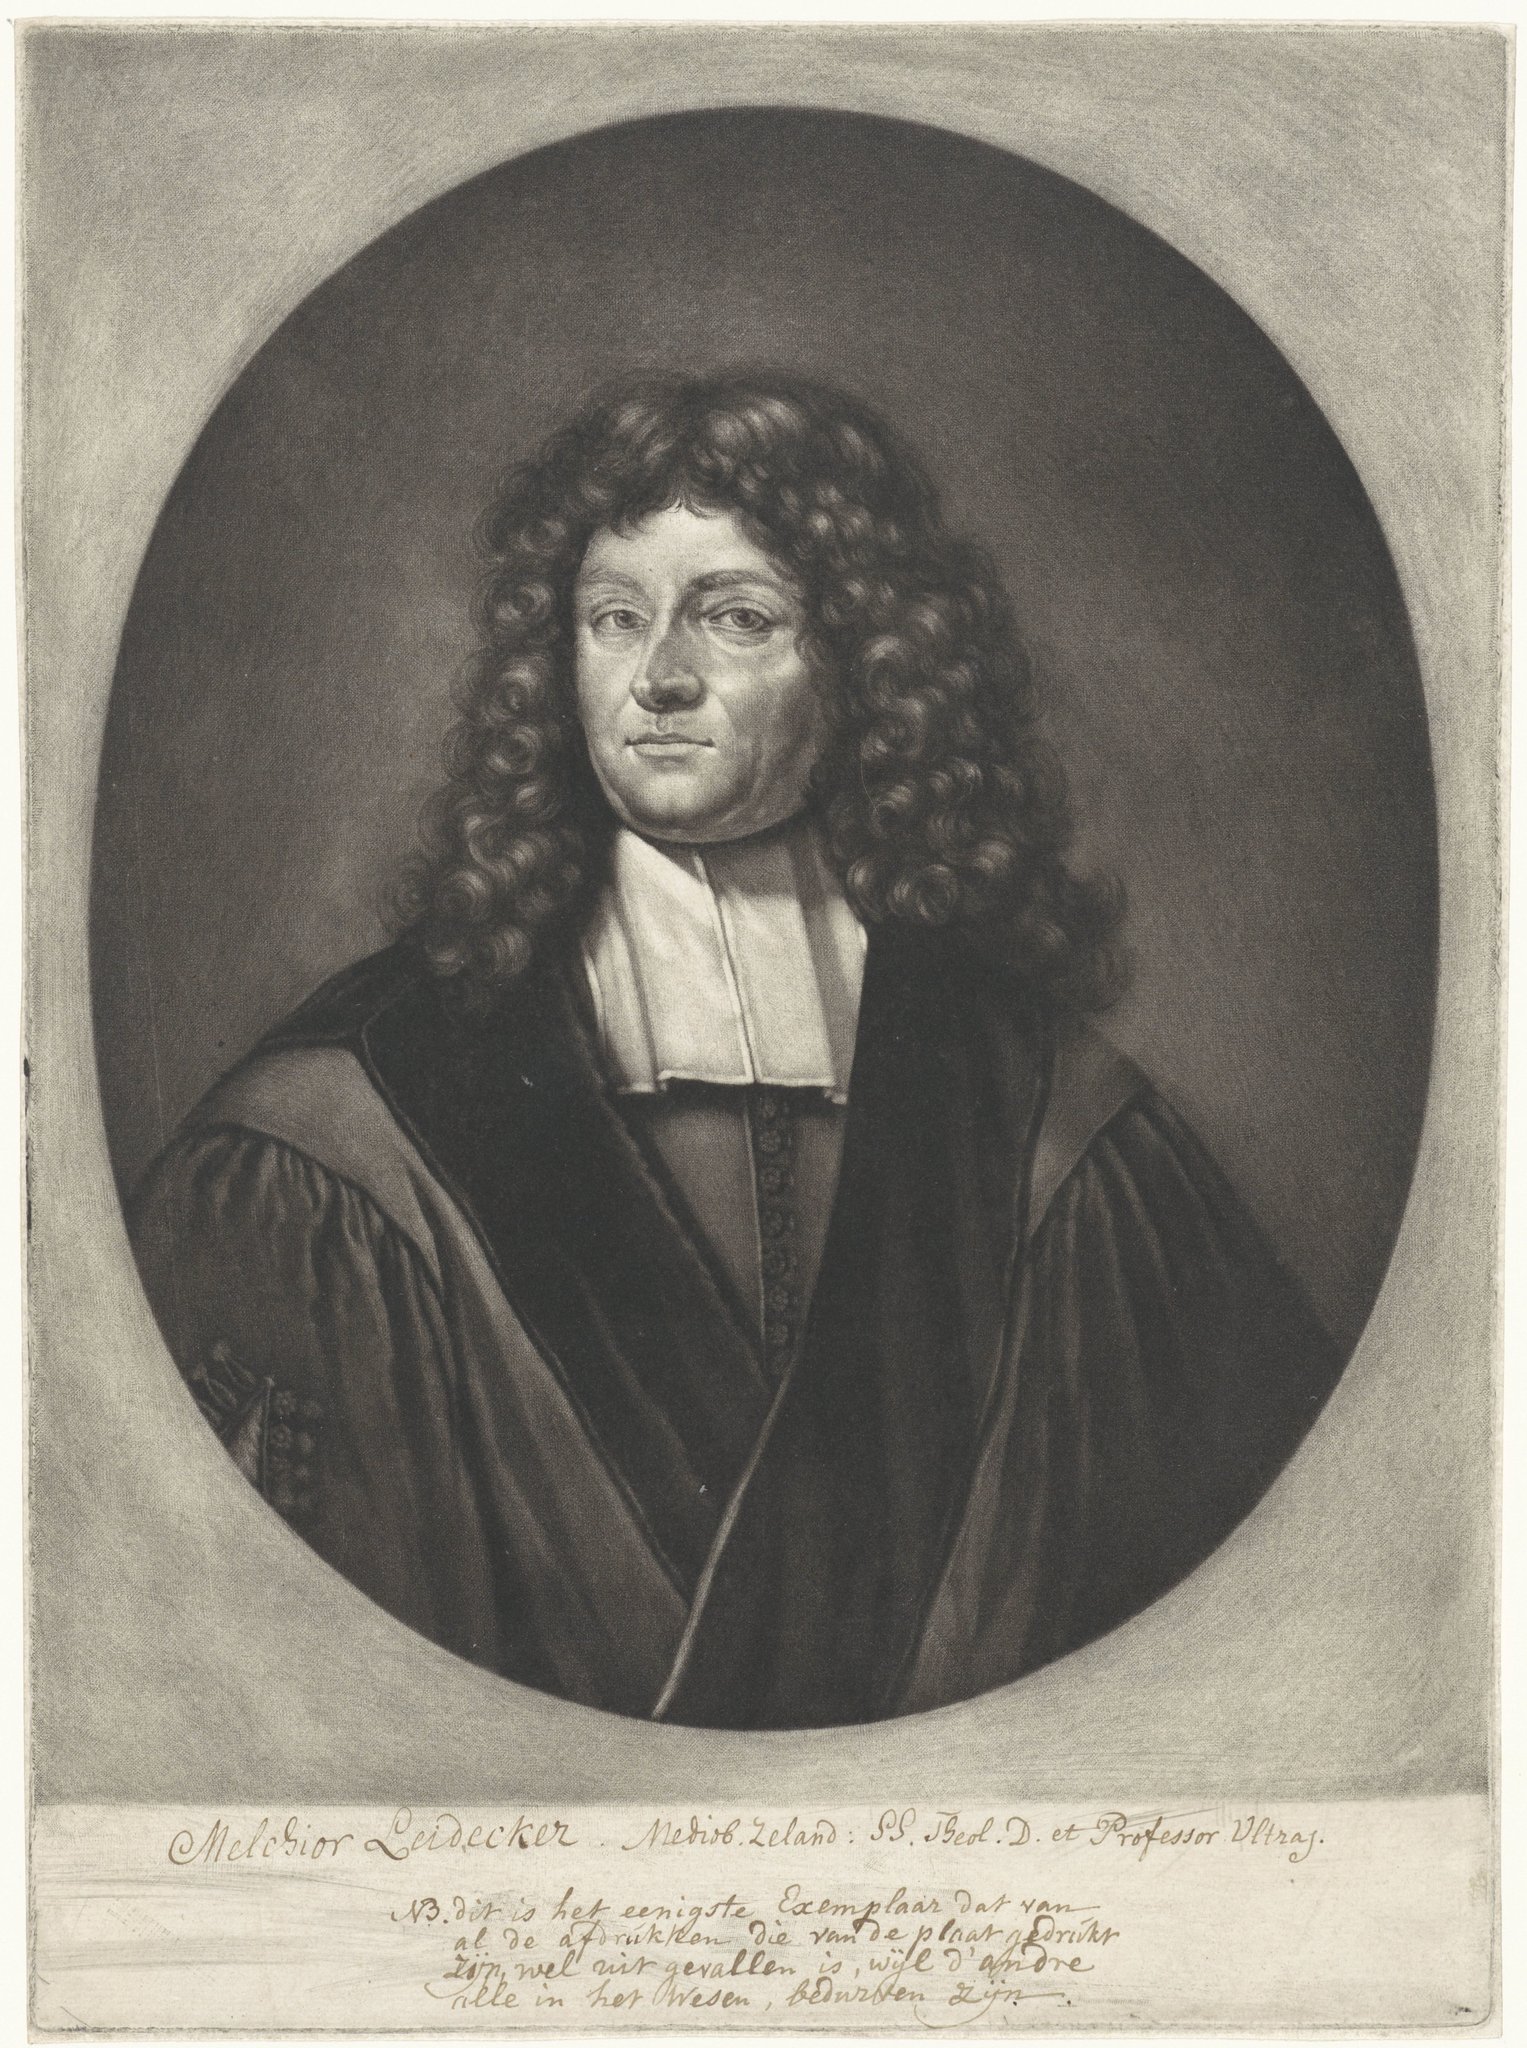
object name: print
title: Portret van de theoloog Melchior Leydekker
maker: pieter schenk (i)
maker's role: print maker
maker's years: 1660-1711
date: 1670-1713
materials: paper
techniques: mezzotint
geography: amsterdam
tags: utrecht, melchior leydekker, theologian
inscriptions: inscription: ‘Melchior Leidecker [...] zijn’, collector's mark: Lugt 2228